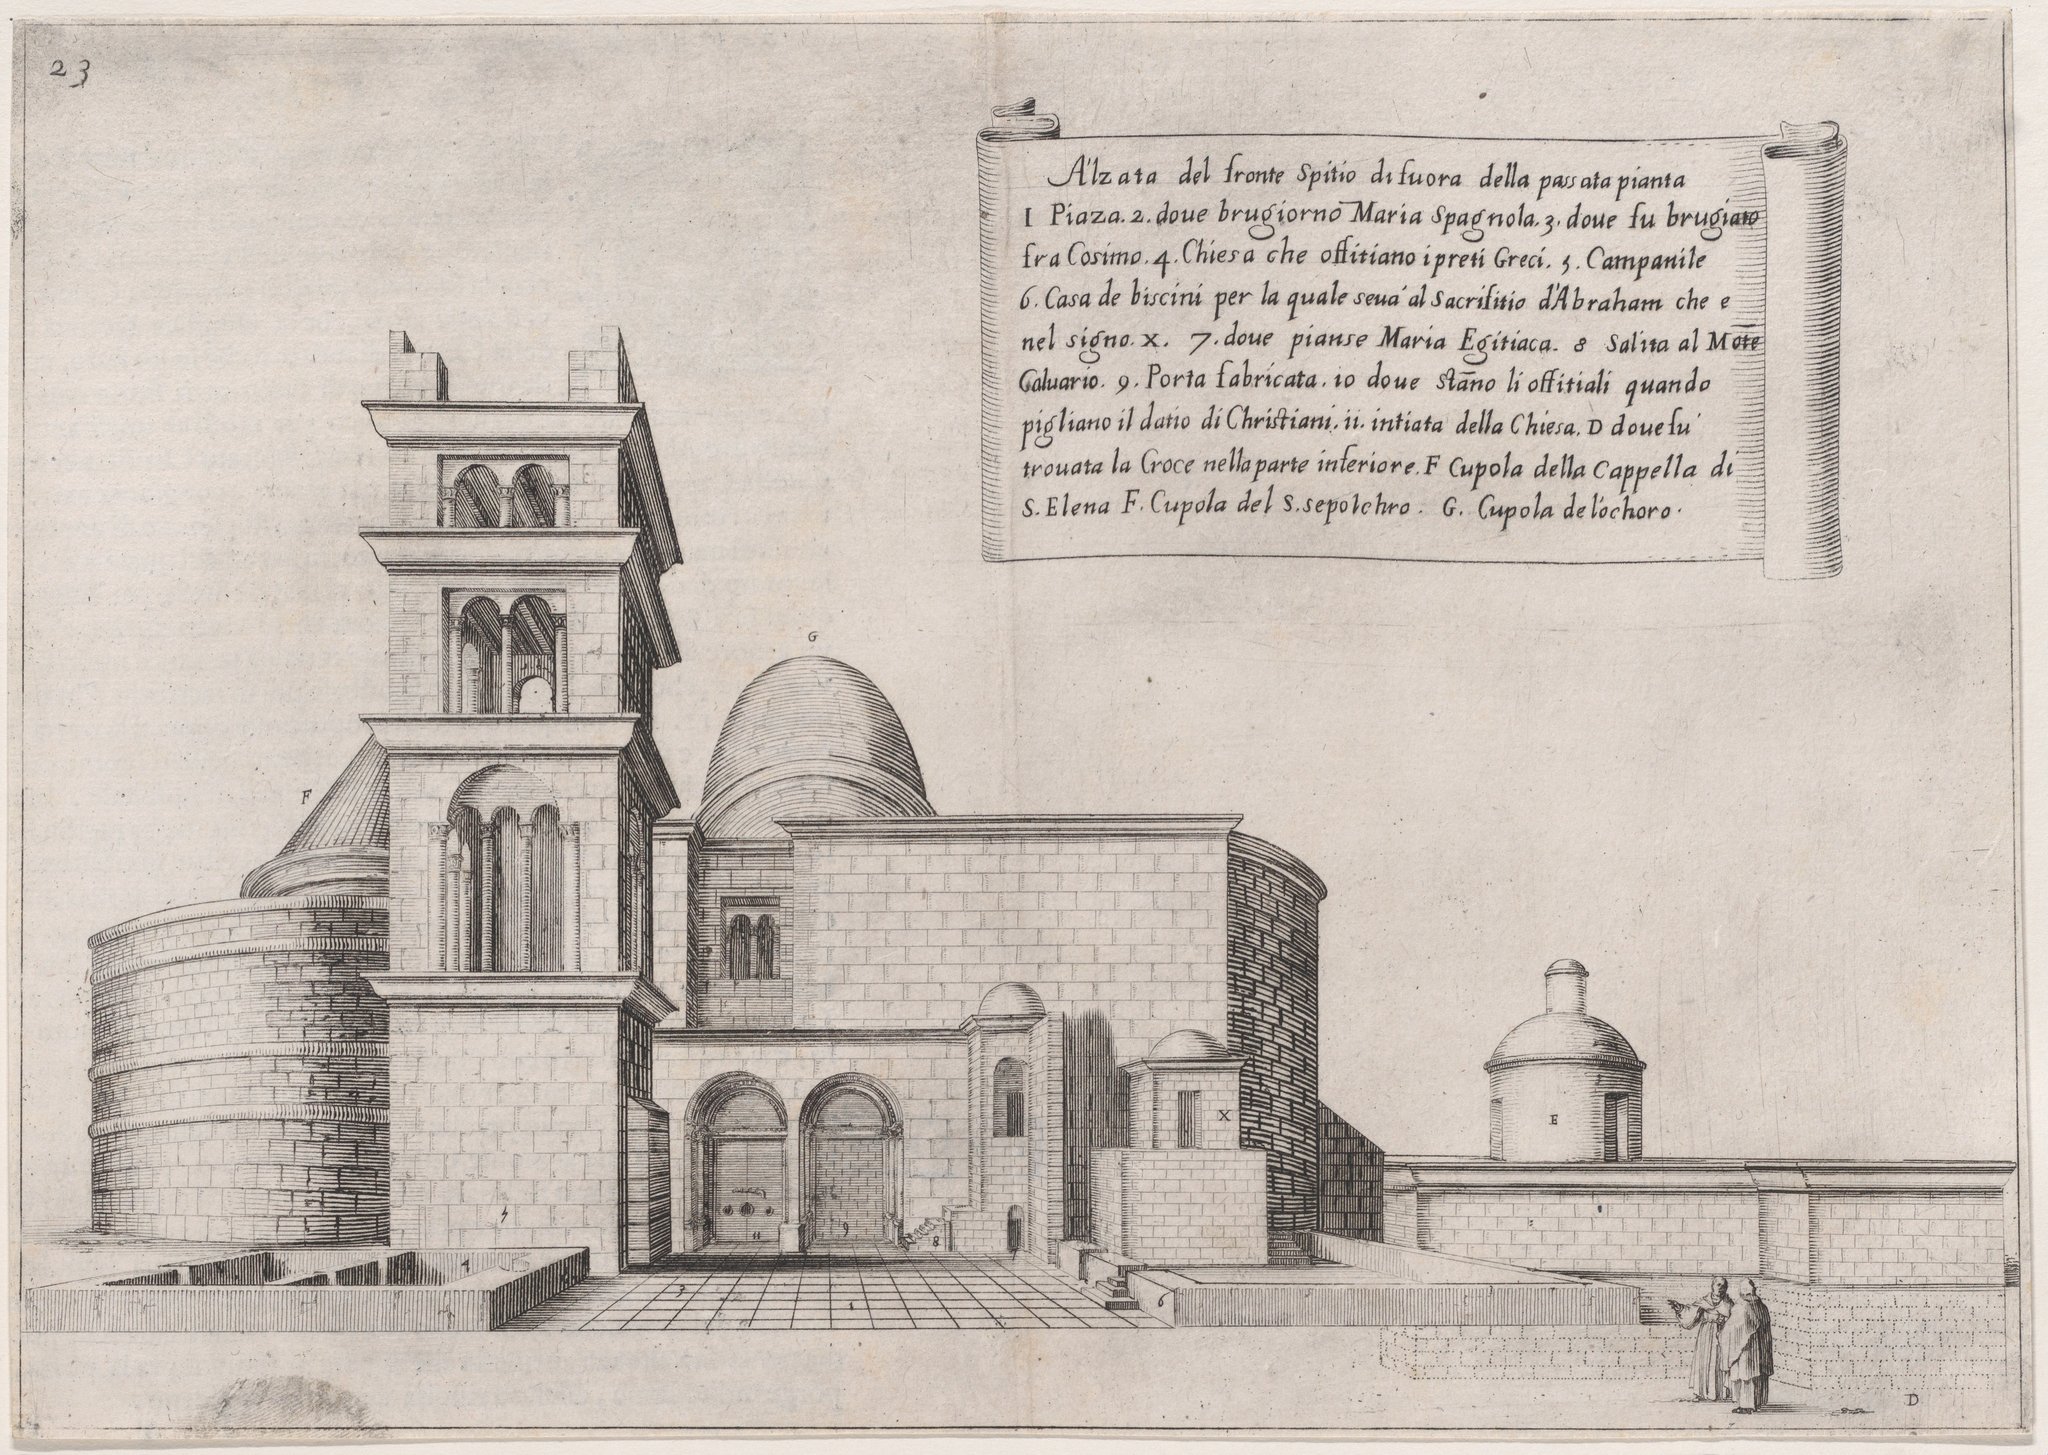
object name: print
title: Plate 19, from "Trattato delle Piante & Immagini de Sacri Edifizi di Terra Santa" (Treatise of the Plans & Images of the Sacred Buildings of the Holy Land)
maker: jacques callot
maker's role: artist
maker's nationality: french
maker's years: 1592-1635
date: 1620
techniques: engraving, etching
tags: architecture,buildings